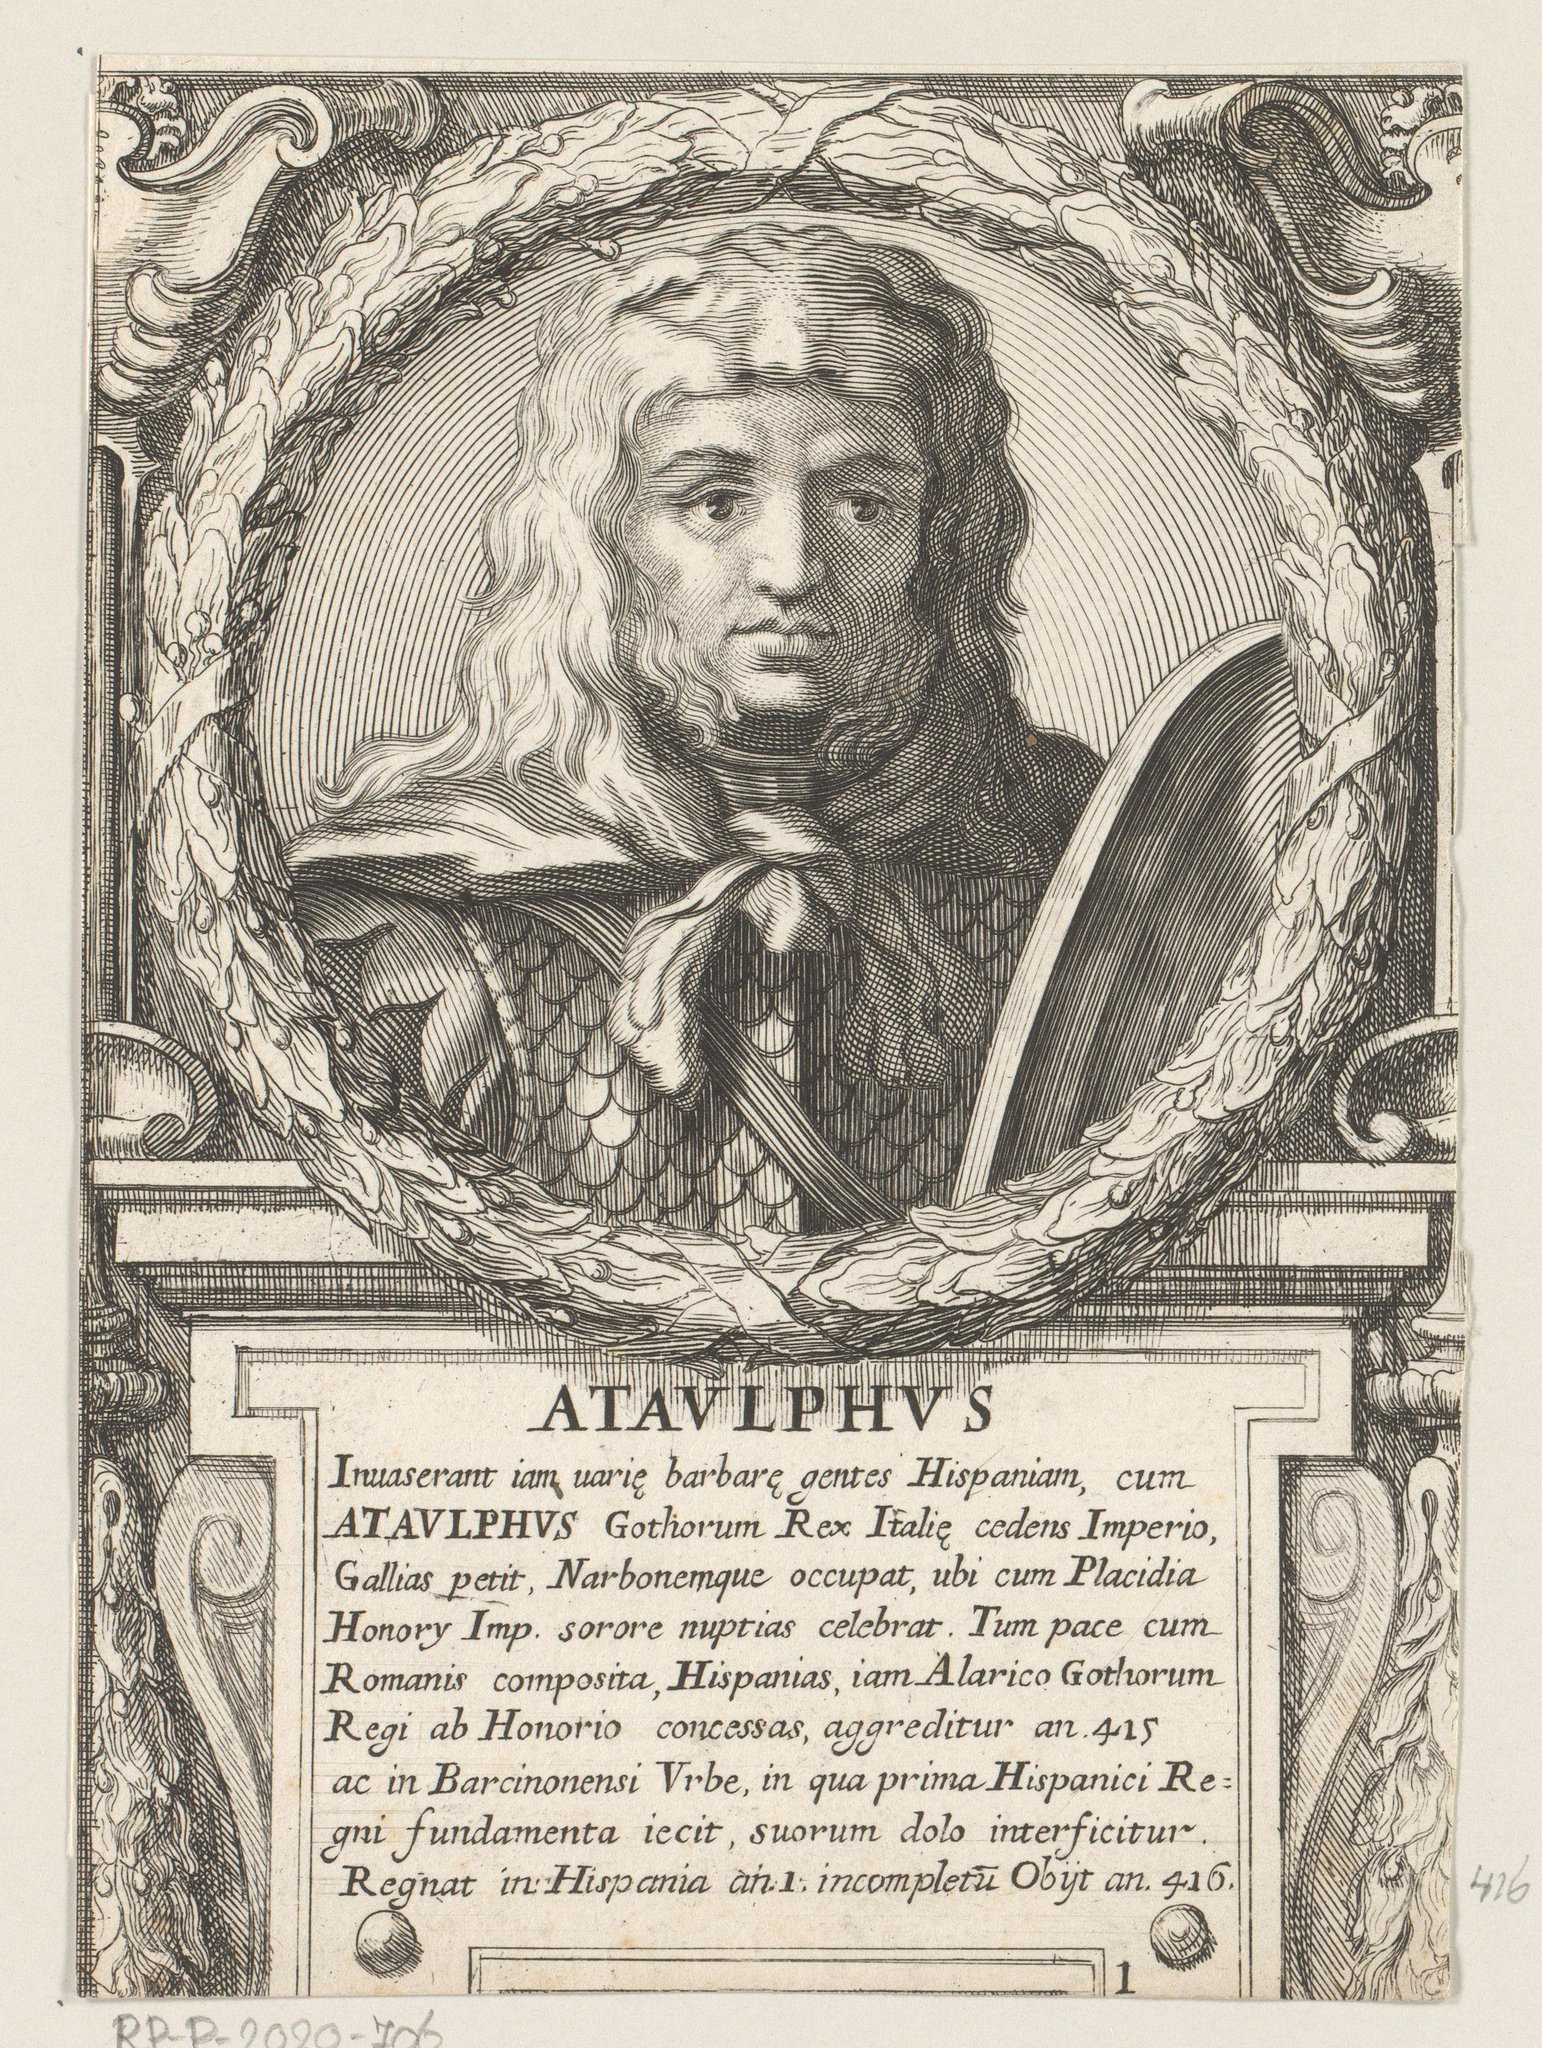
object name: print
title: Series Chronologica et Imagines Regu Hispaniae ab Ataulpho ad Carolum II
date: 1685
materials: paper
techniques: engraving, etching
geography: rome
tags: historical persons, ruler, sovereign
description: Portret afkomstig van een grote prent, getiteld 'Series Chronologica et Imagines Regu Hispaniae ab Ataulpho ad Carolum II', bestaande uit tien bladen die samengevoegd konden worden, uitgegeven door Giovanni Giacomo de' Rossi in 1685.